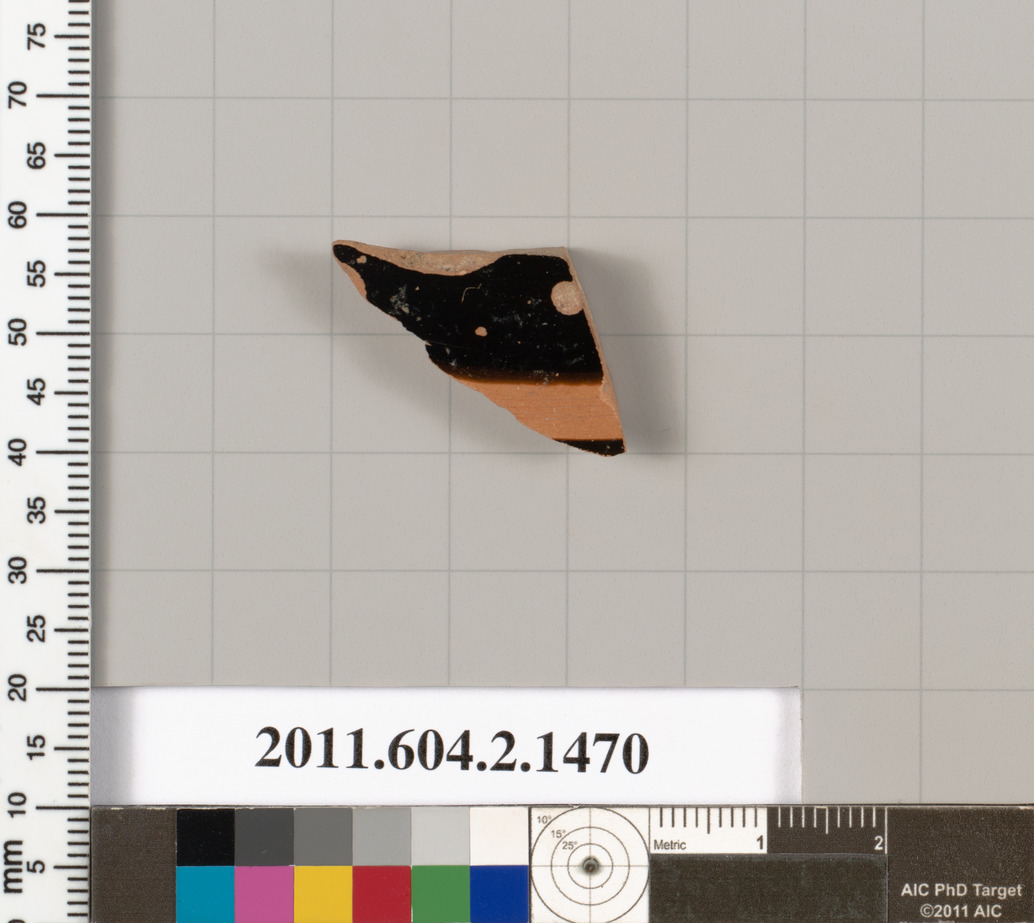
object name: skyphos fragment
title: Terracotta fragment of a skyphos (deep drinking cup)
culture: greek, attic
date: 500-401 BCE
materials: terracotta